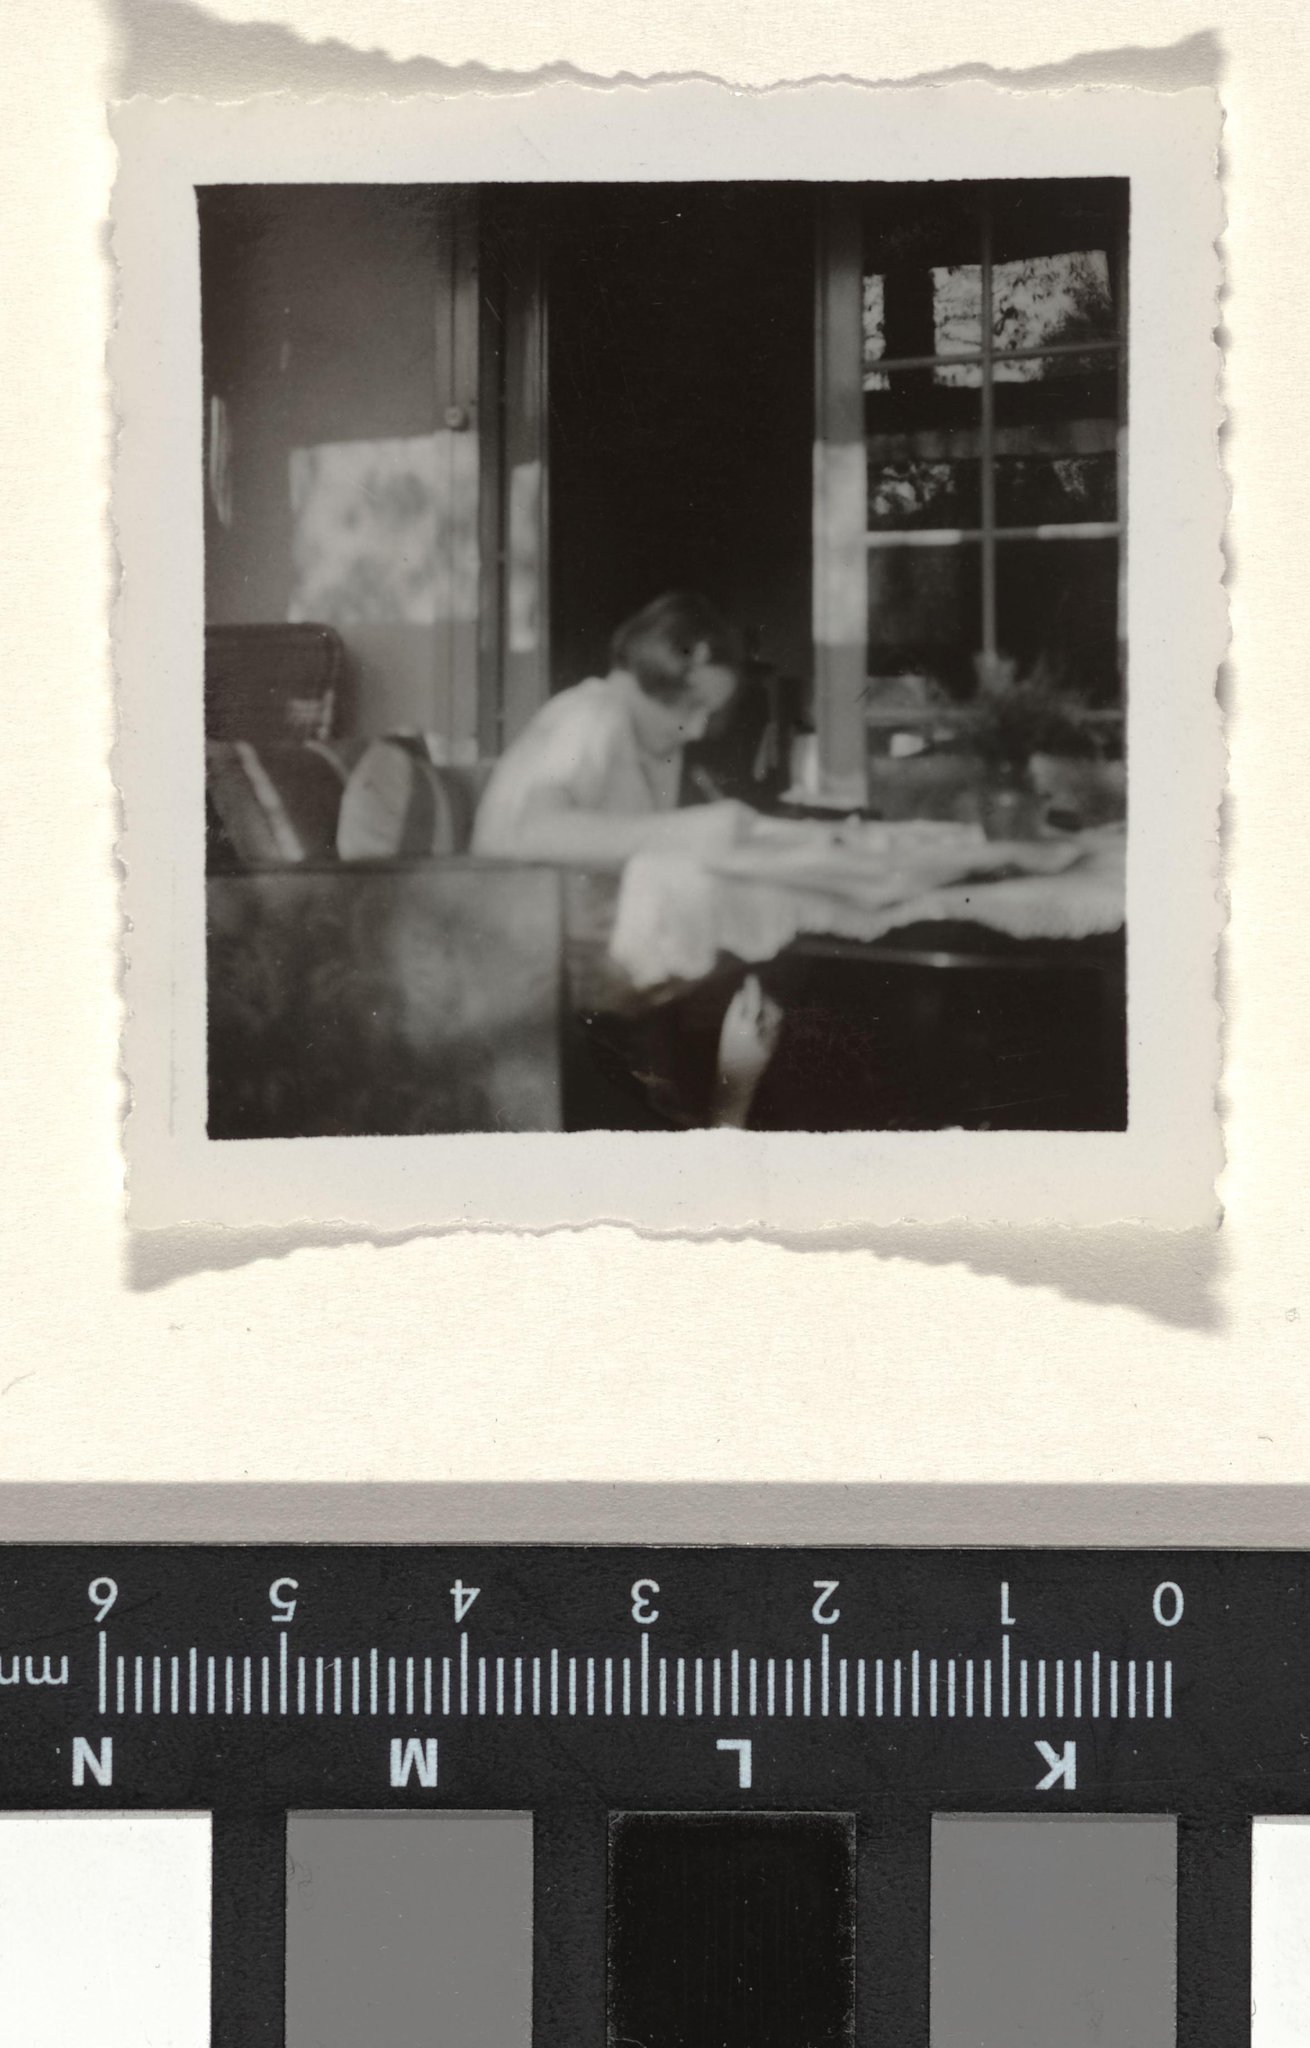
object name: photograph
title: Isabel Wachenheimer gezeten in een stoel en werkend aan een tafel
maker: Anonymous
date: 1933-1940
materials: photographic support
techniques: gelatin silver print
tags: leiden, isabel wachenheimer-elon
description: Isabel Wachenheimer gezeten in een stoel en werkend aan een tafel.